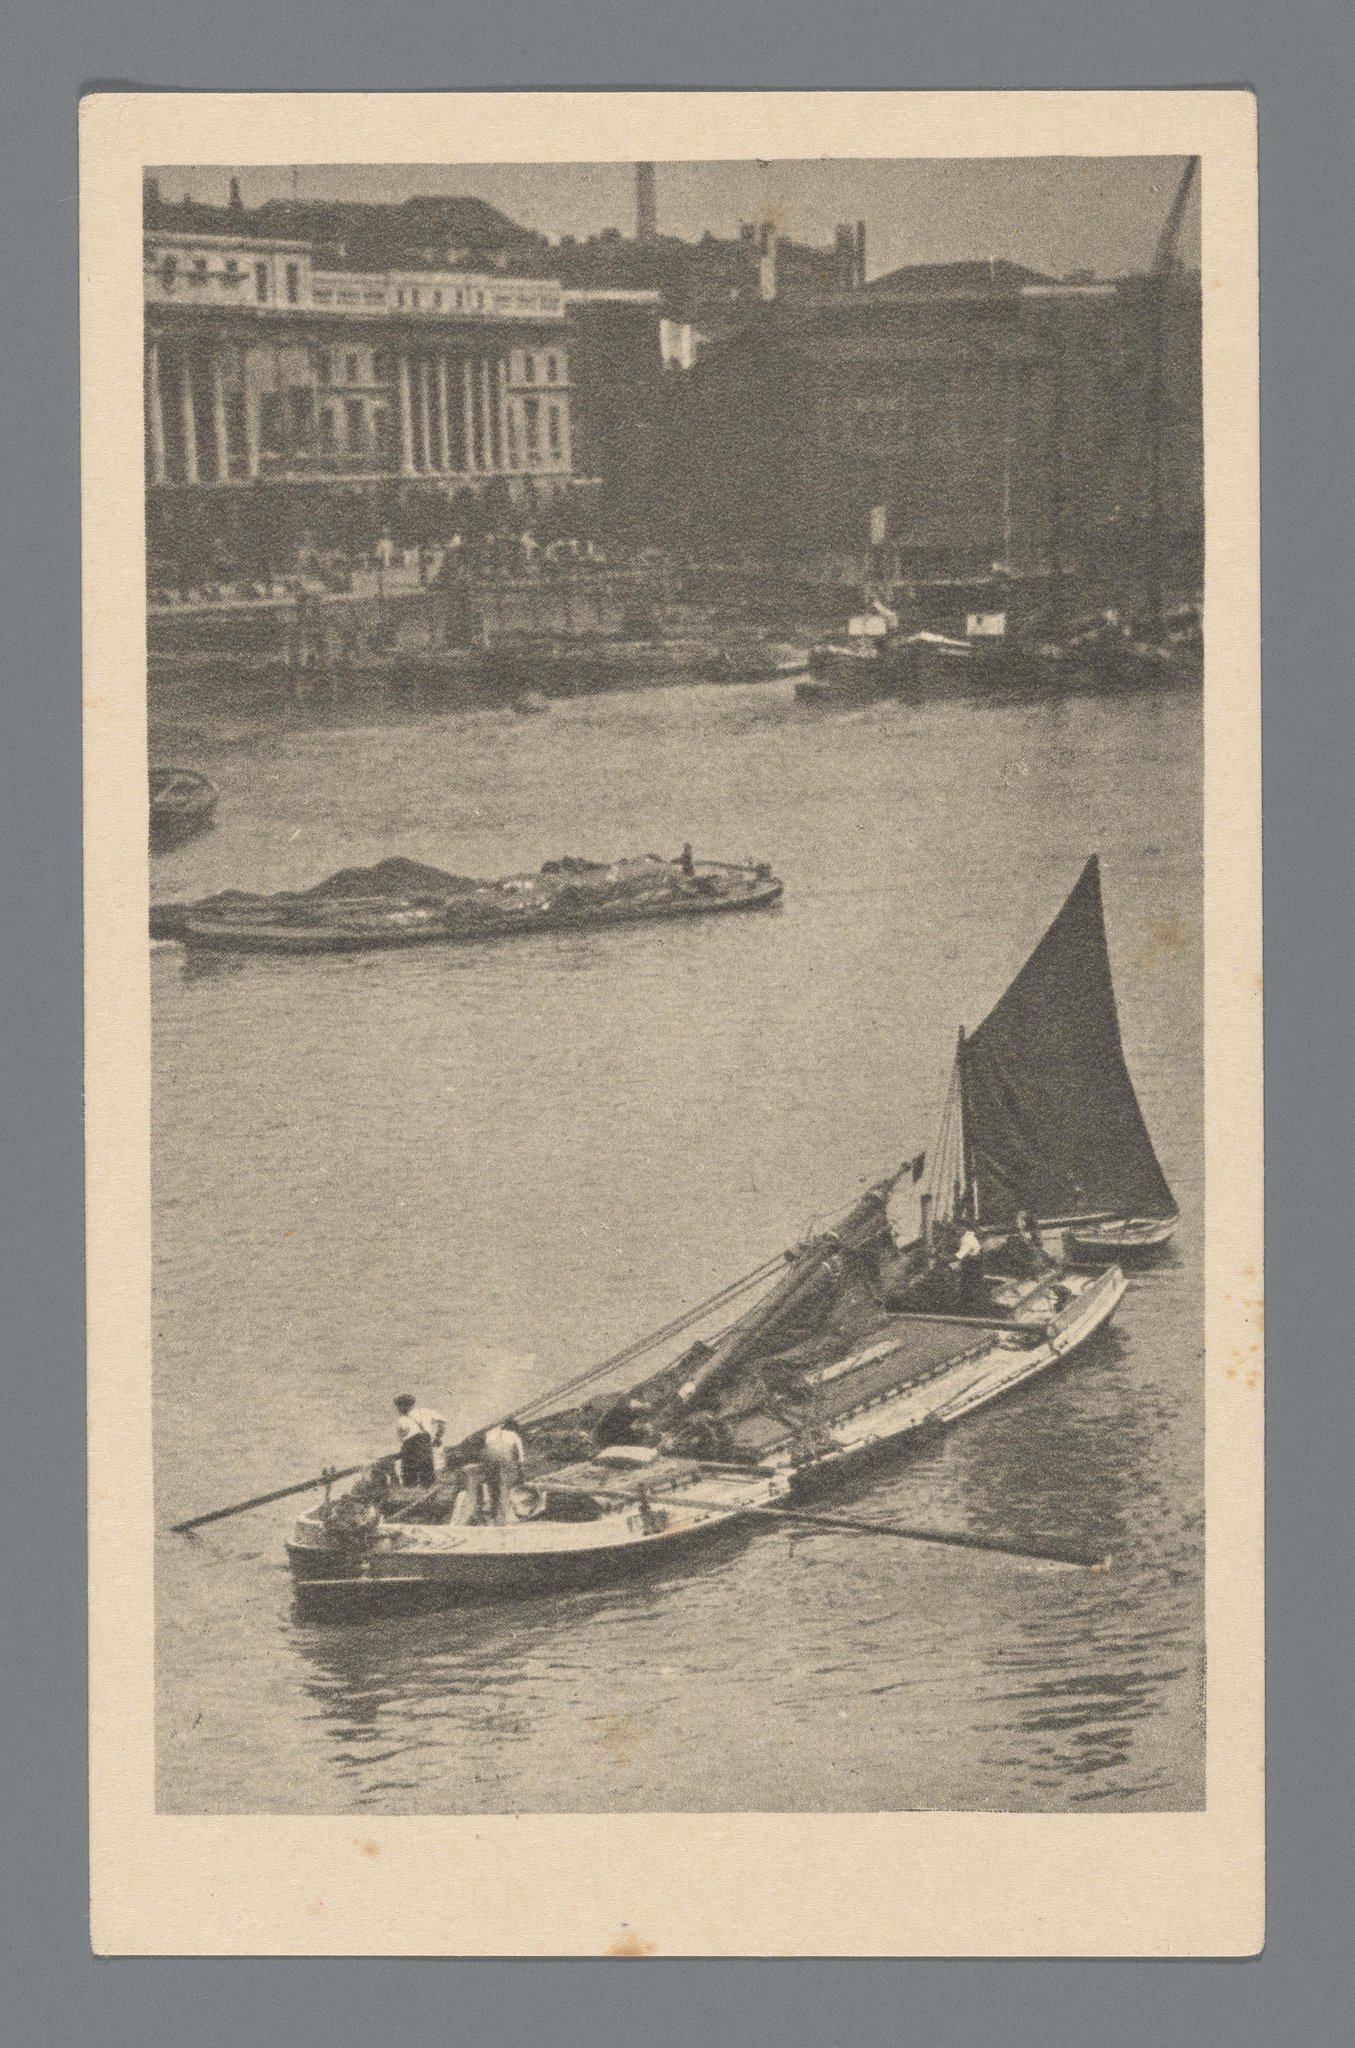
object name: ansichtkaart, prentbriefkaart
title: Gezicht op Custom House aan de Theems met boten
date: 1914-2024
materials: cardboard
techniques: photoaquatint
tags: river, tow-boat, towing-barge, names of historical buildings, sites, streets, etc.